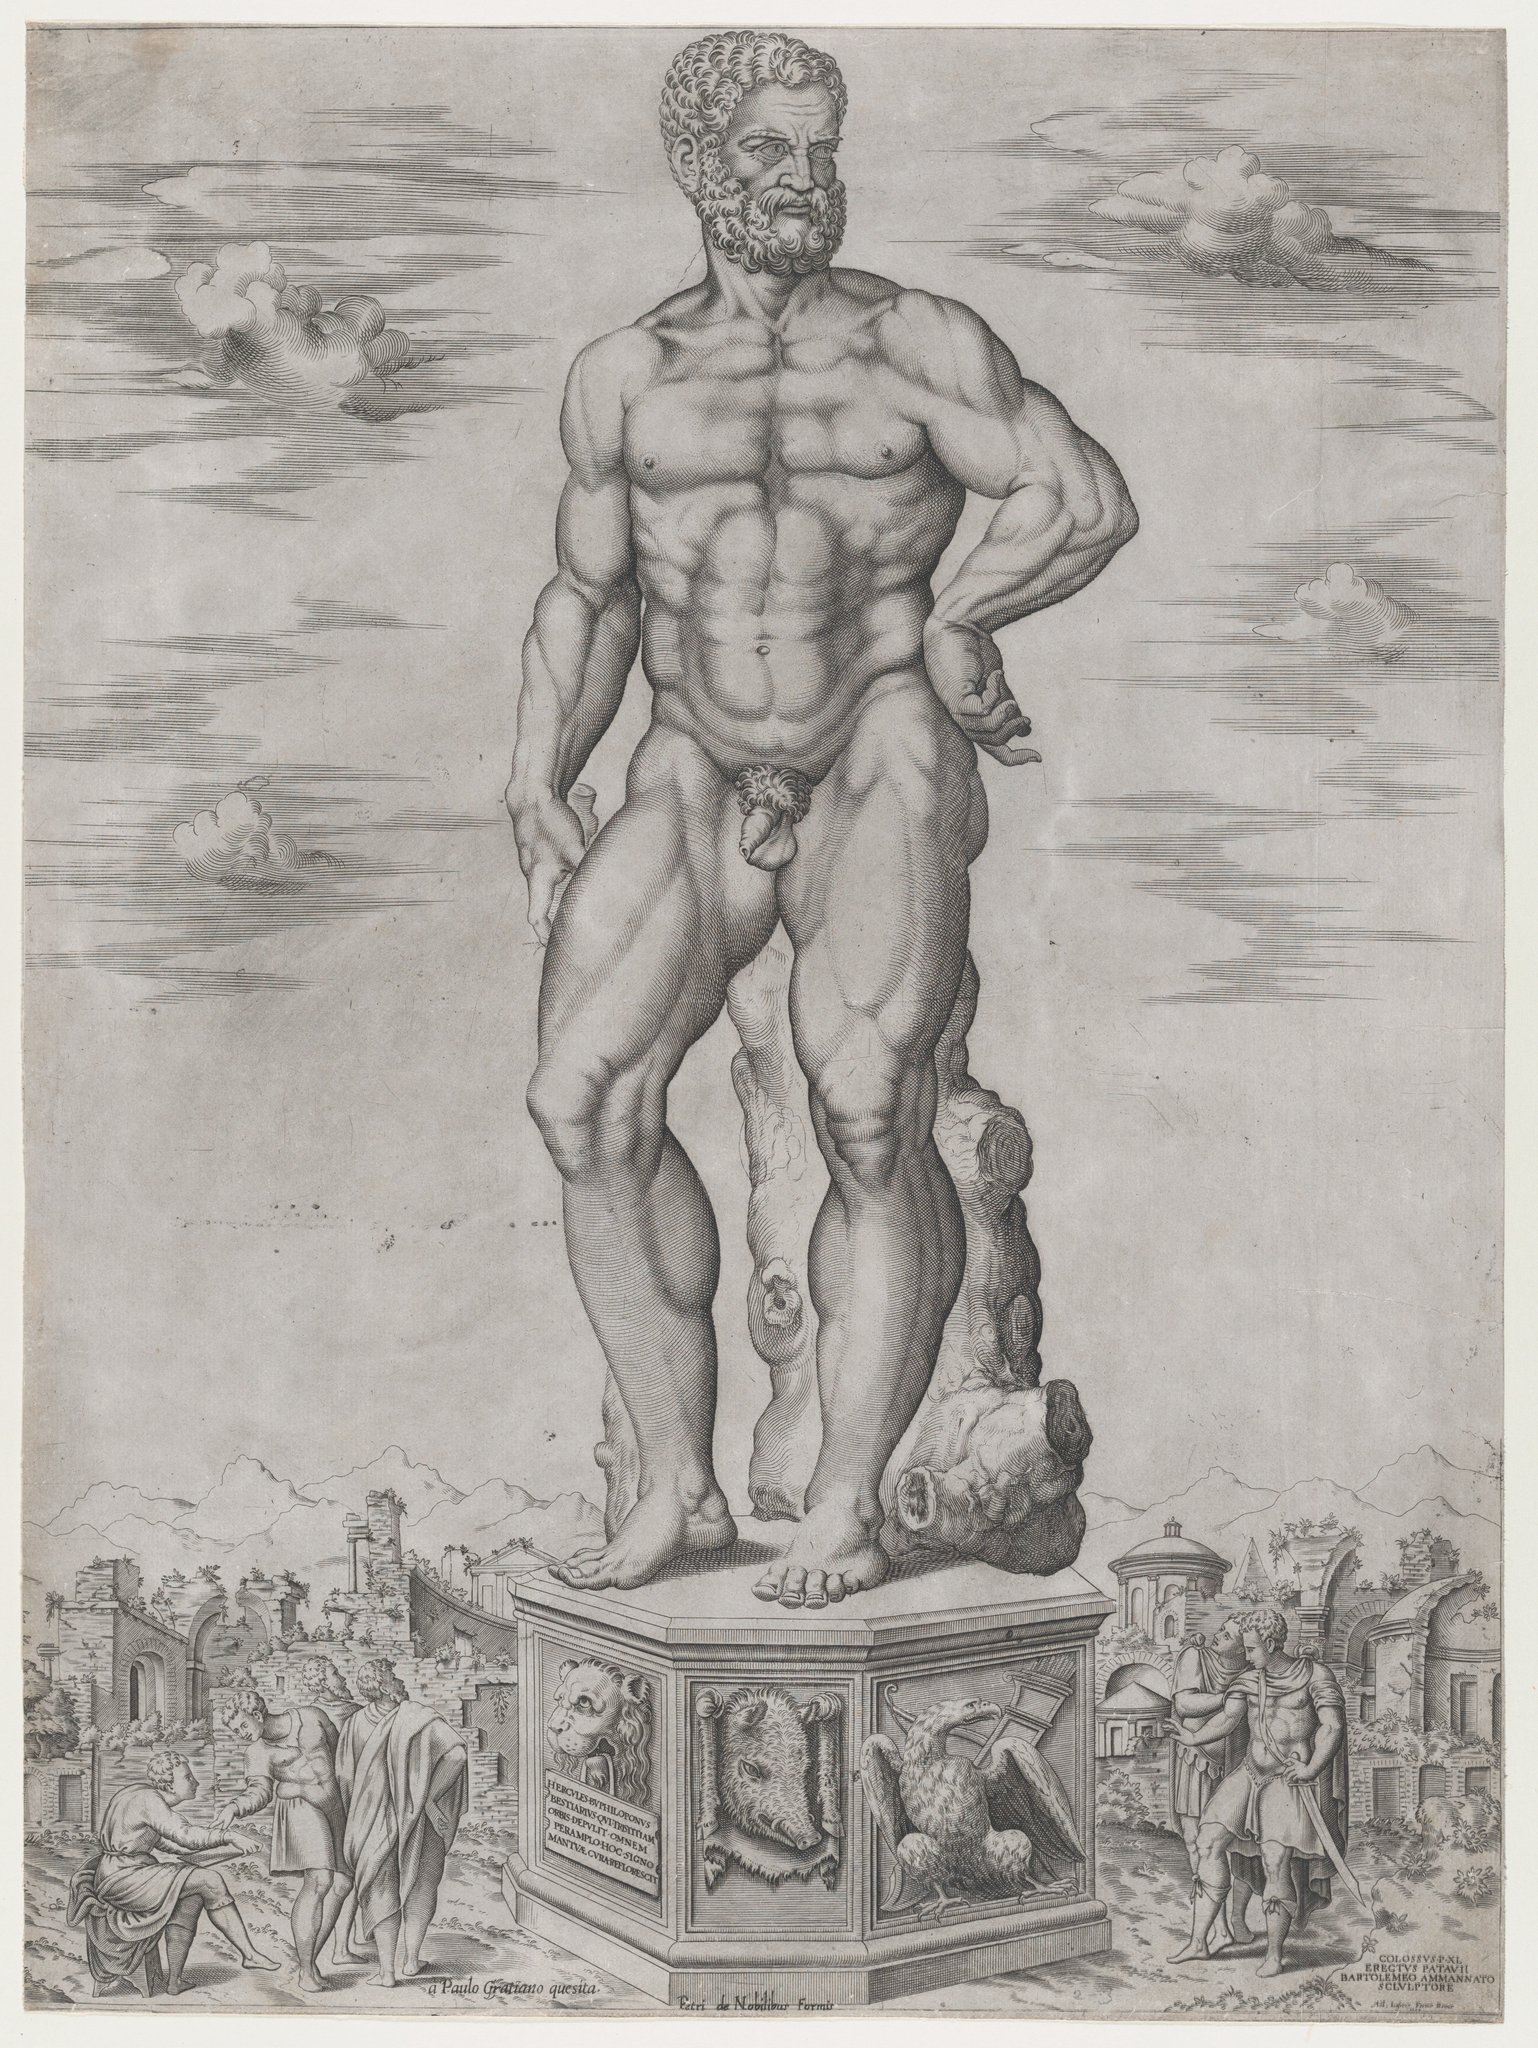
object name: print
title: Hercules Colossus at Padua (L'Ercole di casa Benavides a Padova), from "Speculum Romanae Magnificentiae"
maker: anonymous, italian, 16th century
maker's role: artist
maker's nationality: italian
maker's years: 1500-1600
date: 1553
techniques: engraving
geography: rome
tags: hercules